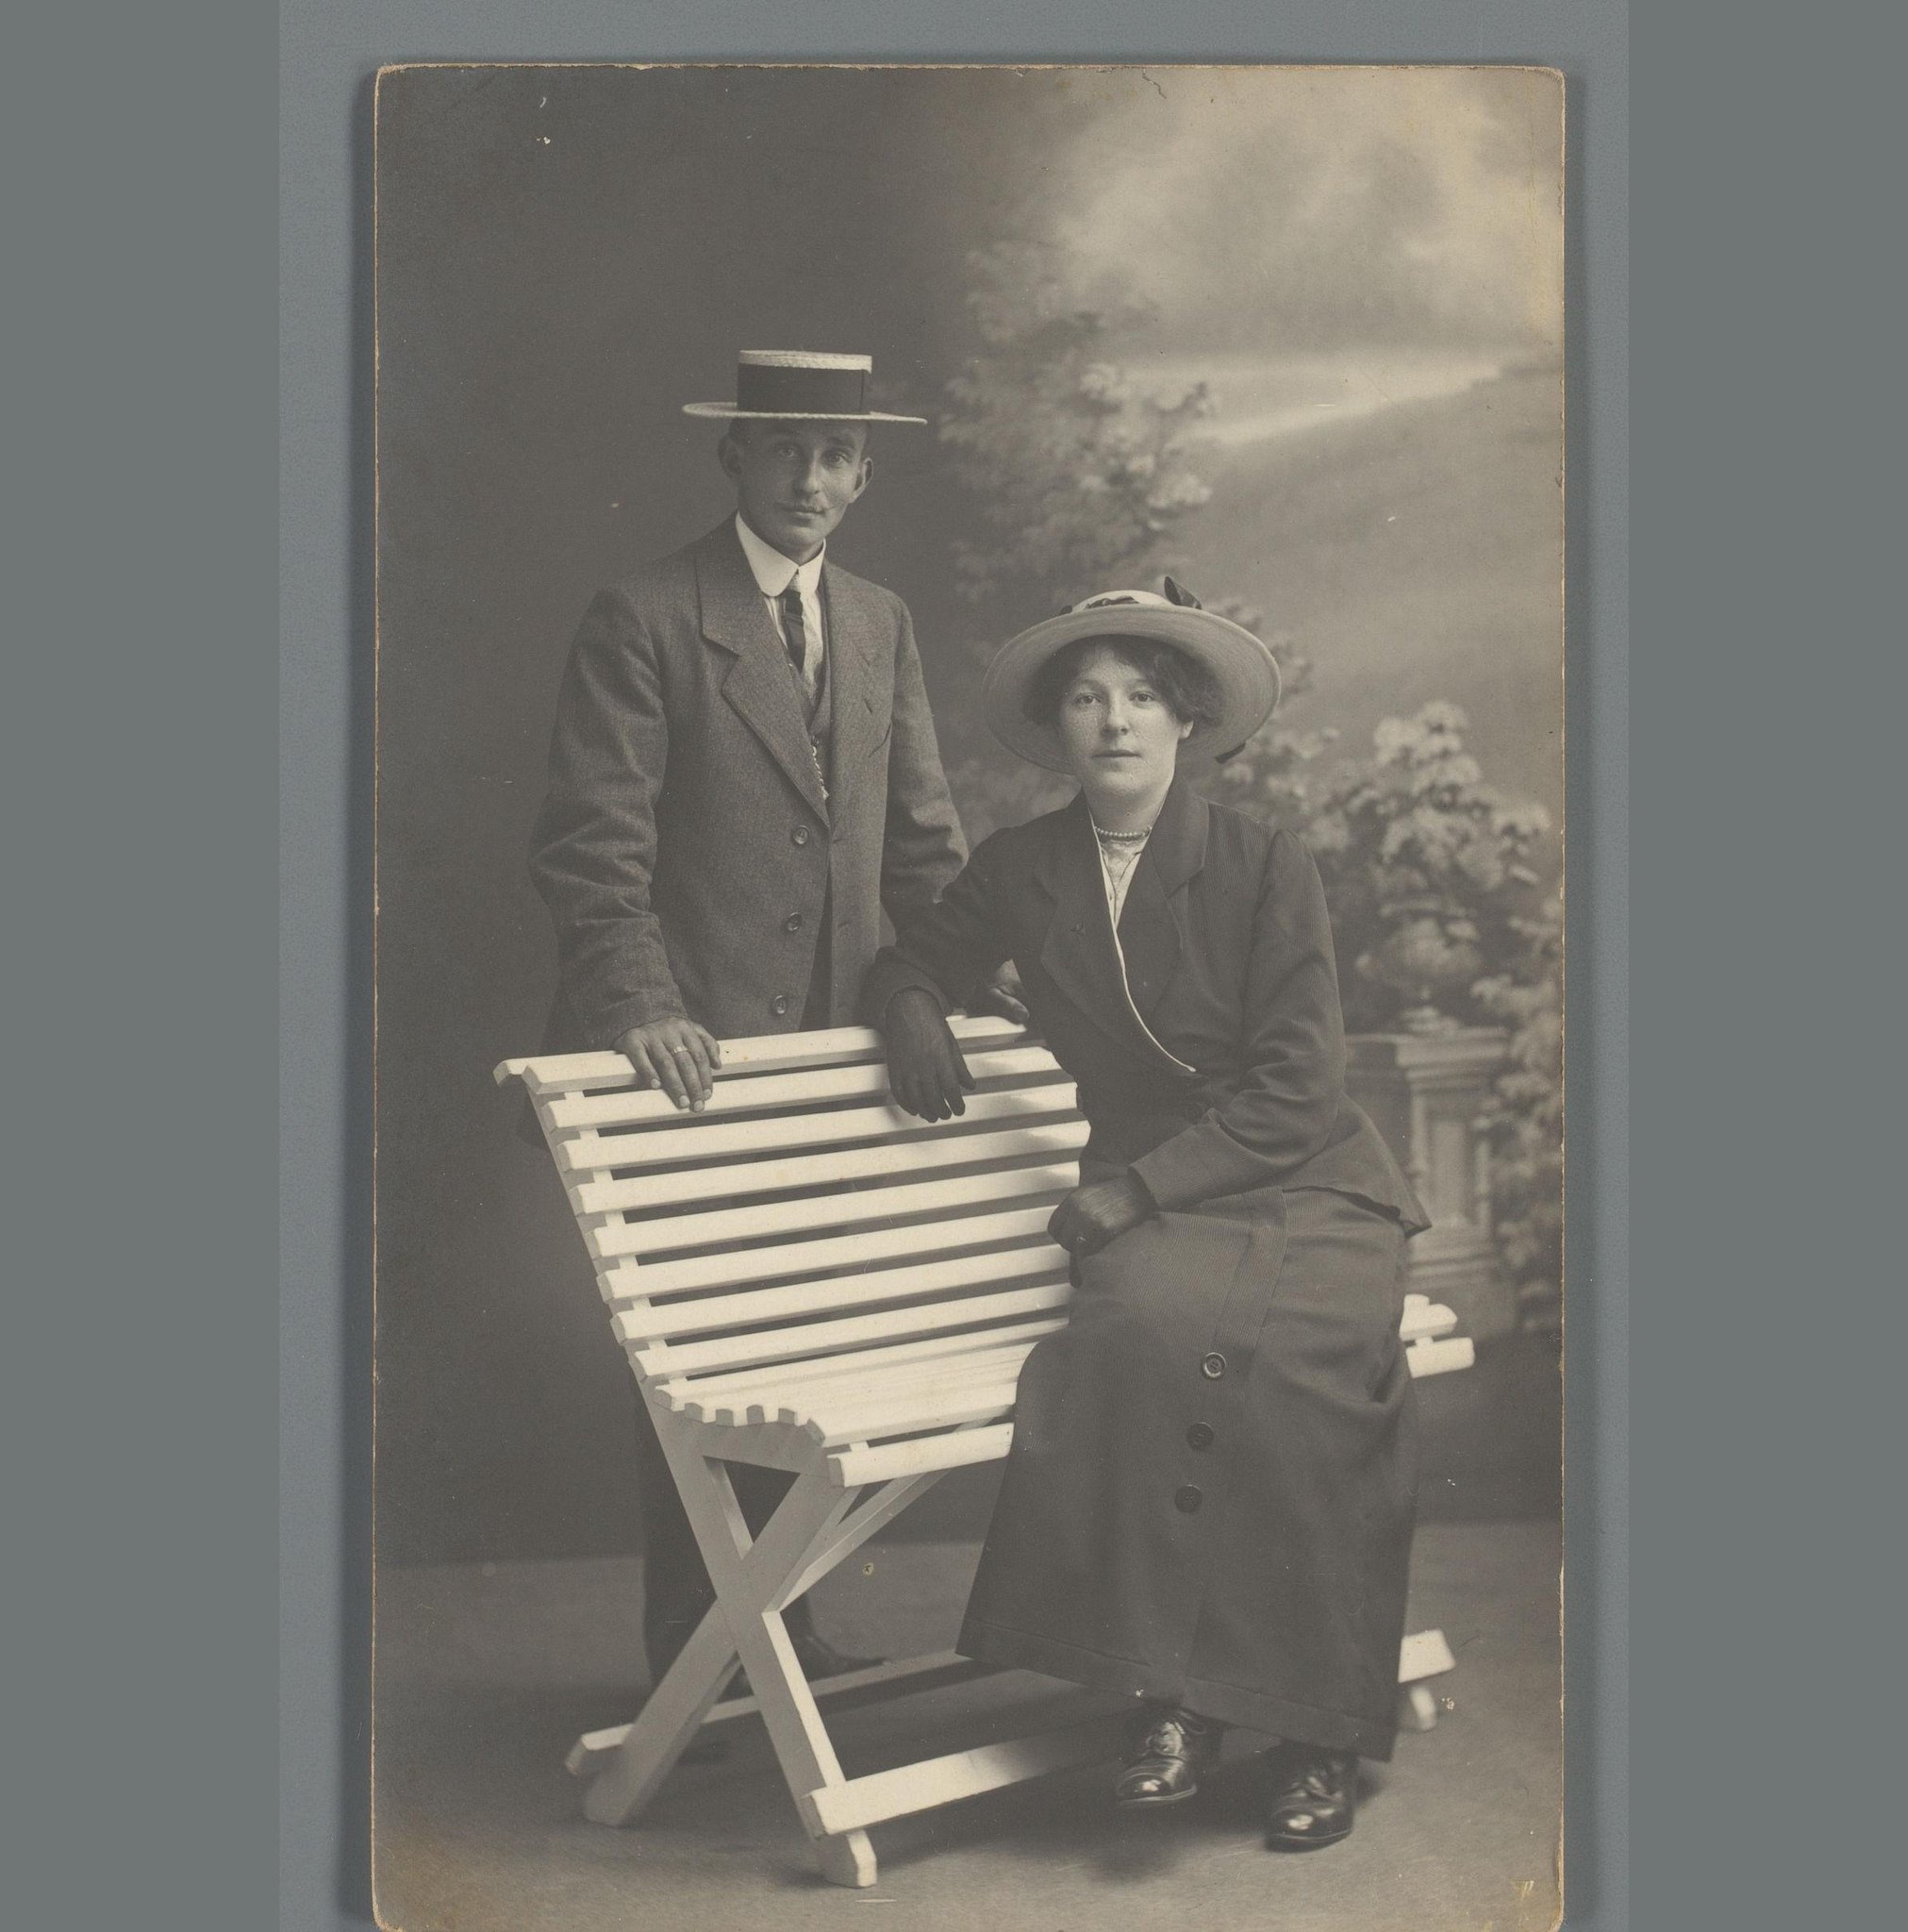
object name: ansichtkaart, prentbriefkaart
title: Portret van een onbekende man en vrouw in een fotostudio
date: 1910-1920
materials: paper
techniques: gelatin silver print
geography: sneek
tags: historical persons not known by name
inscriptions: inscription: ‘om Barm/ met vriendin’, stamp: ‘Foto de Jong/ Sneek, Klein Zand’